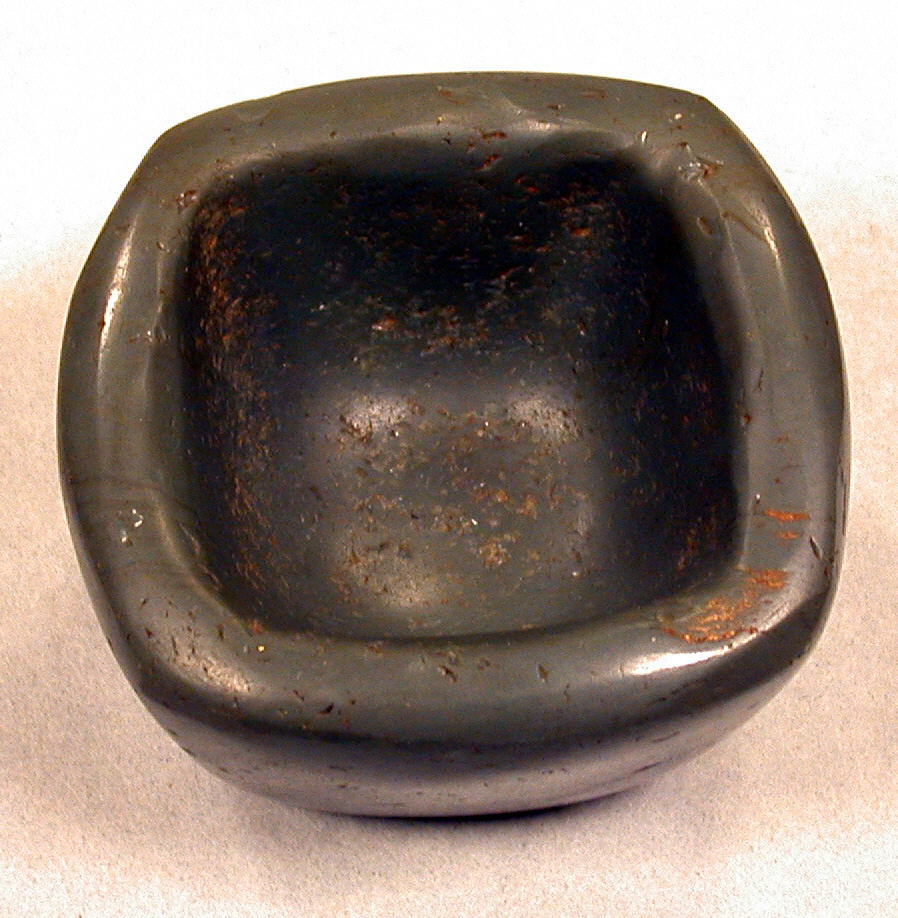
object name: bowl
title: Square Obsidian Bowl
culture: mexican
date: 1501-1600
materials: obsidian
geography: mexico